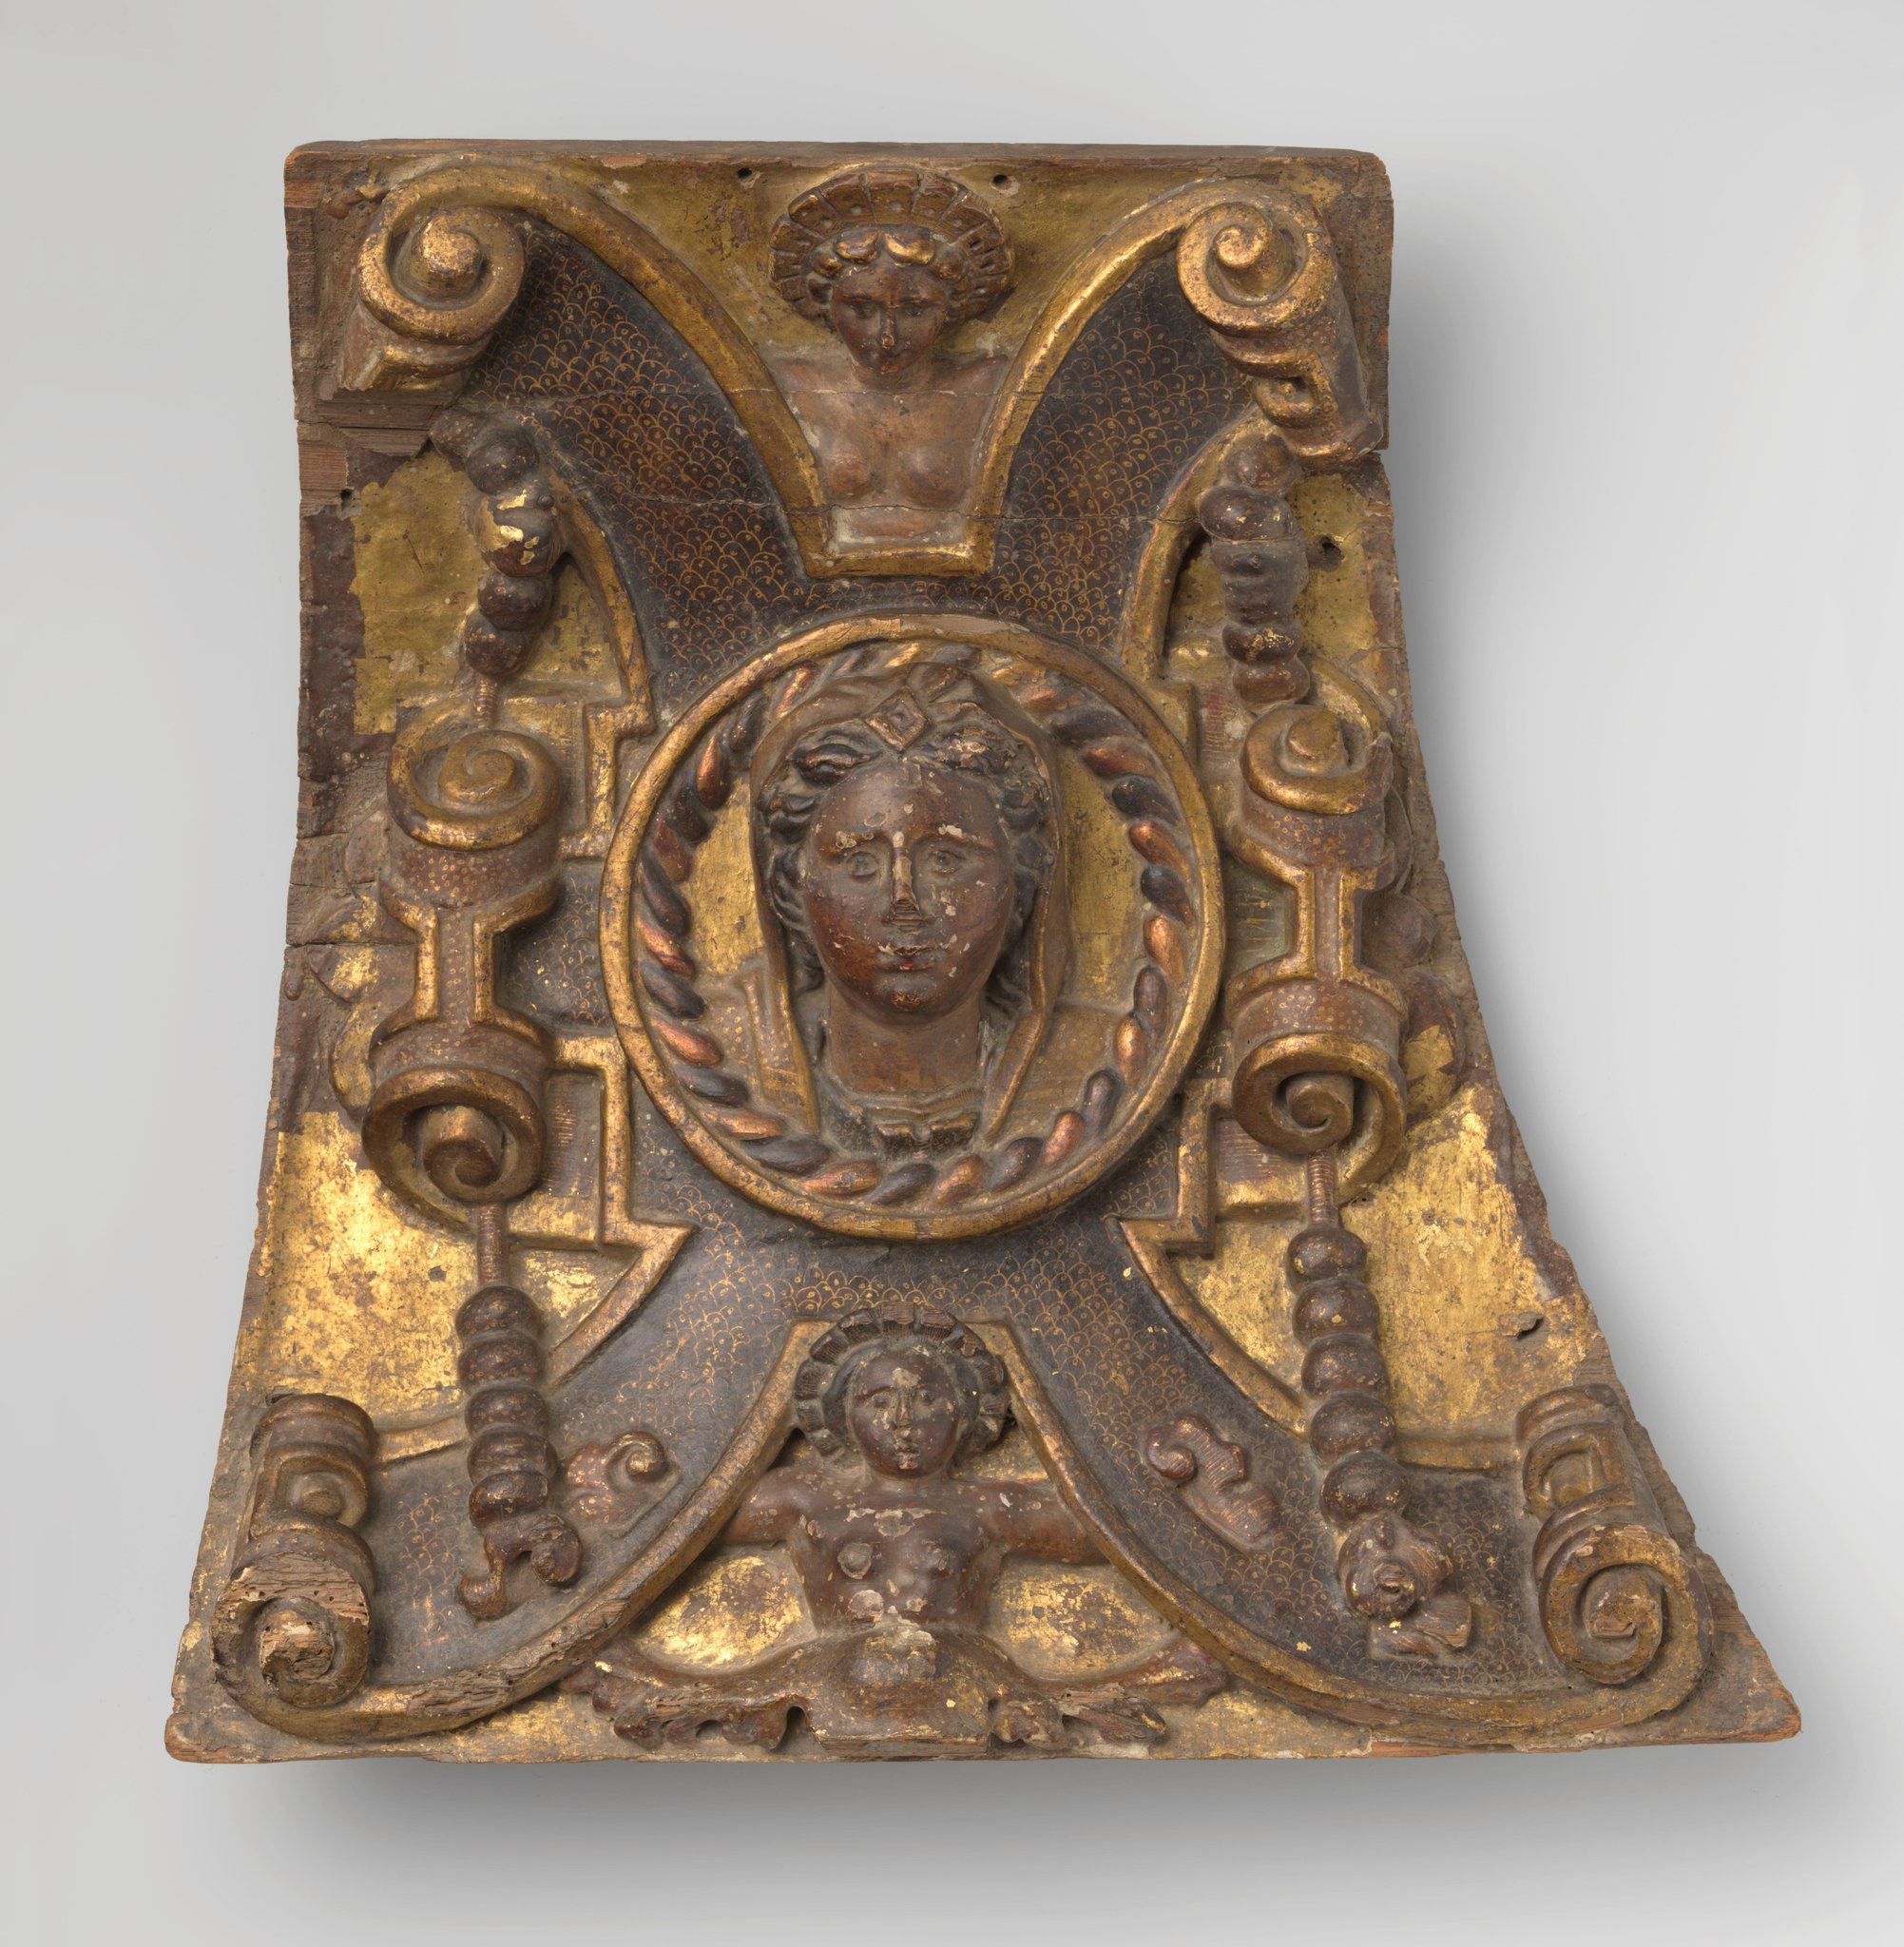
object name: koof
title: Koof, versierd met rolwerkcartouche met medaillon met gesluierde vrouwenkop, gepolychromeerd en verguld grenen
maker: Anonymous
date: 1550-1599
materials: wood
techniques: polychromy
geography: southern netherlands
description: Koof van grenenhout, gepolychromeerd. De in hoog reliëf aangebrachte versiering bestaat uit een rolwerk-cartouche, waarop een medaillon met gesluierde vrouwenkop. Boven en onder een klein vrouwenborstbeeld. Het beeldhouwwerk is gepolychromeerd over een goudlaag, en plaatselijk met goud gehoogd.